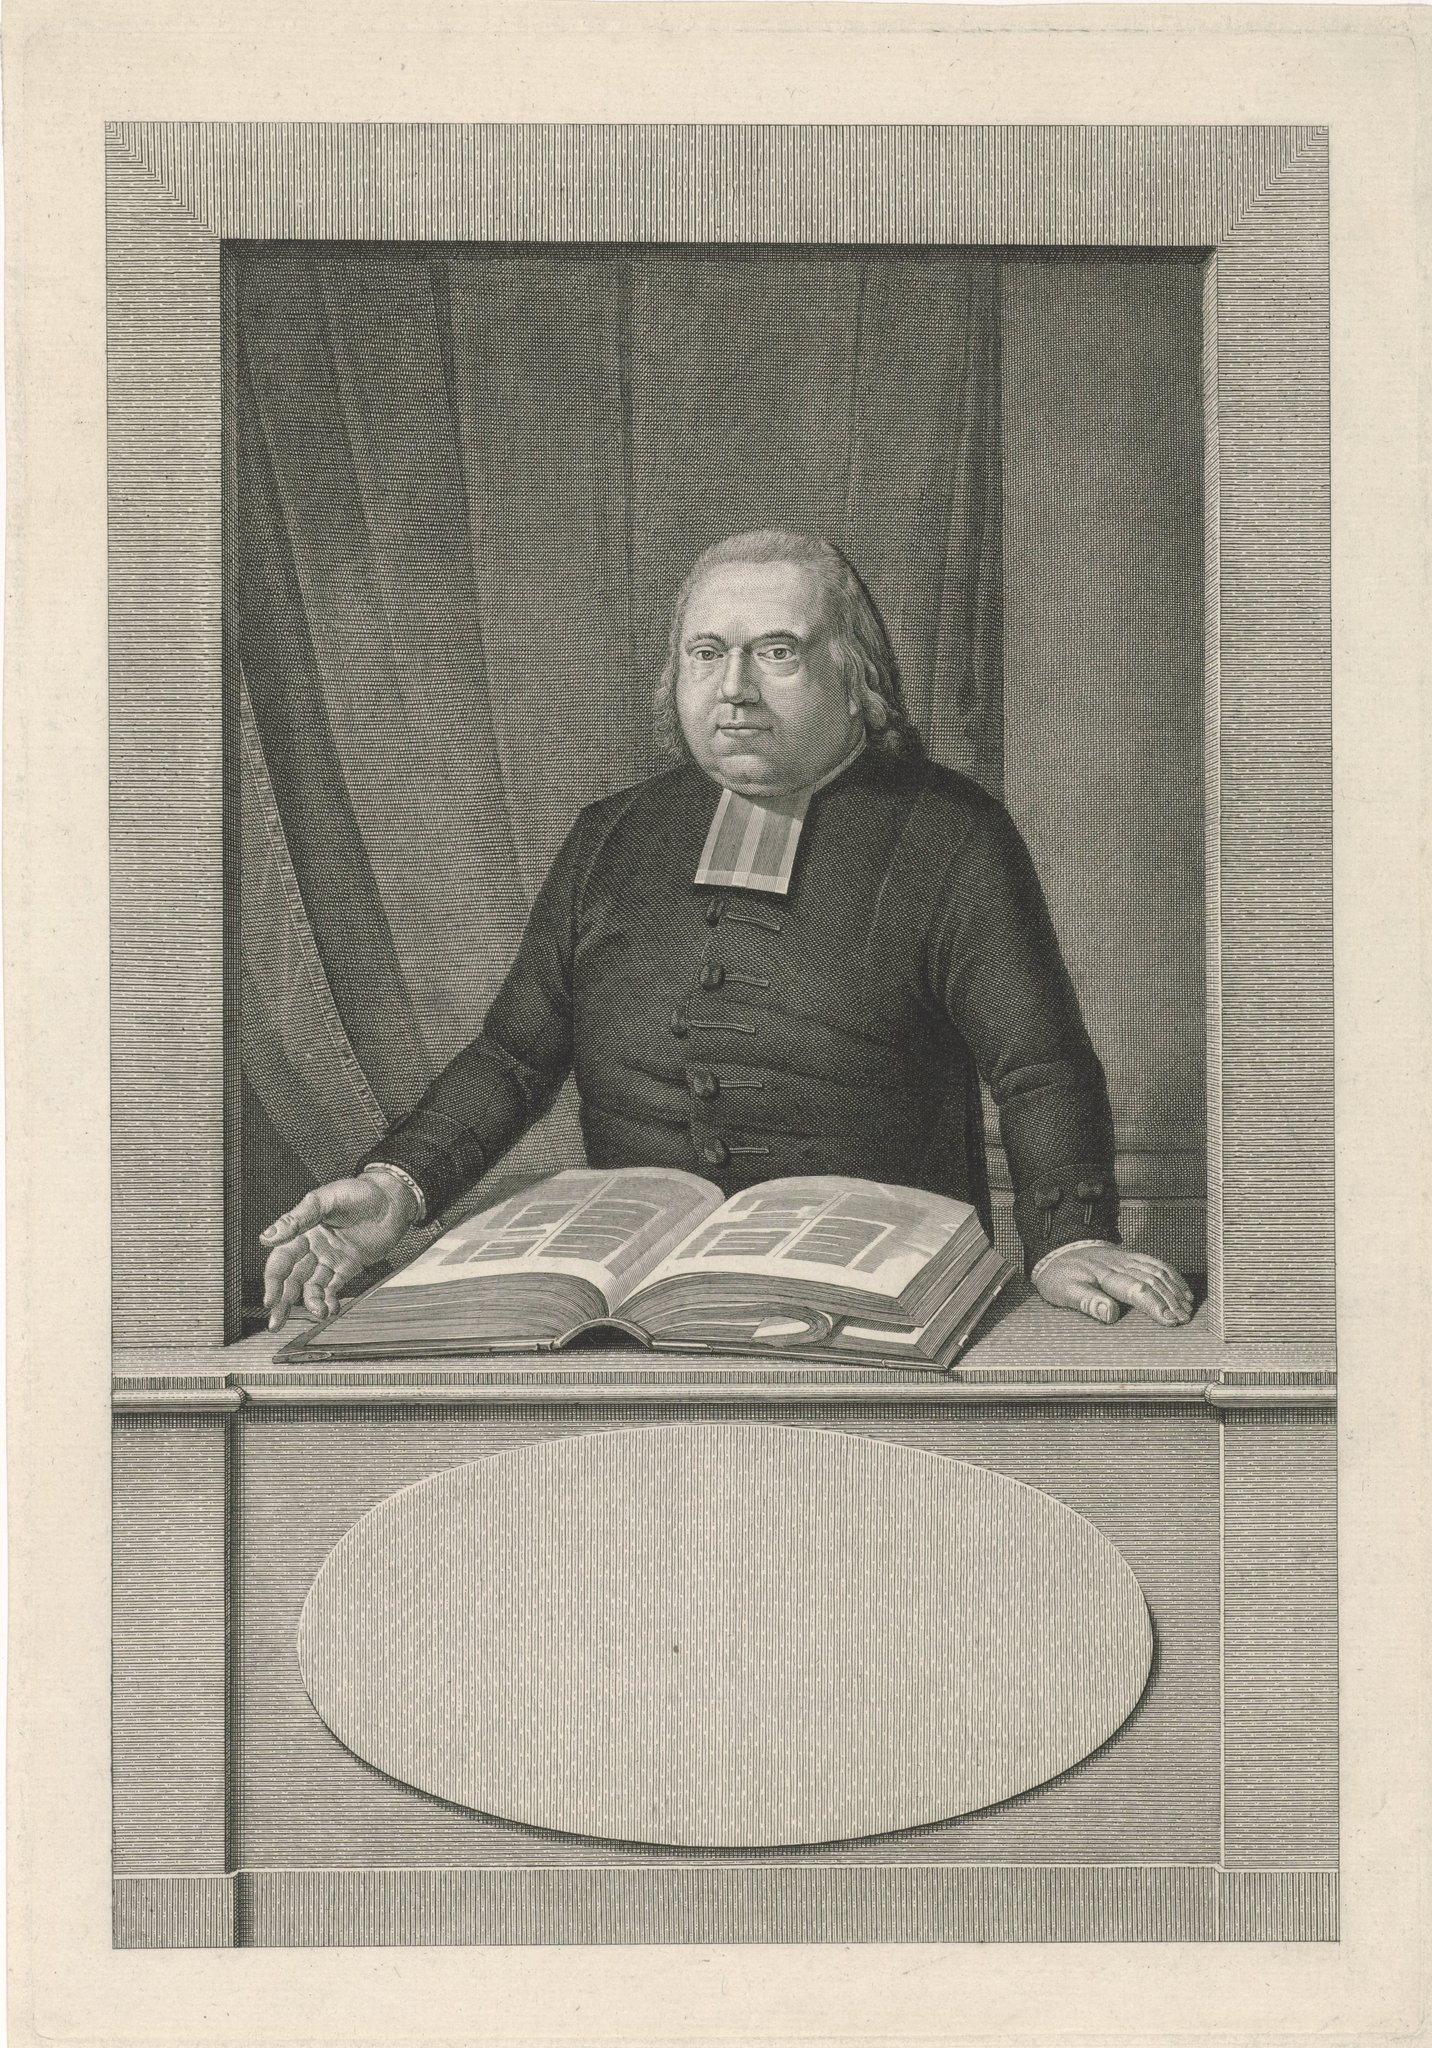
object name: print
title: Portret van Theodorus Isaäcus Gerhardus van Essen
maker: noach van der meer (ii)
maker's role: draughtsman, print maker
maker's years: 1741-1822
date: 1792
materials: paper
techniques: engraving, etching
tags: the bible as a book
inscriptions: collector's mark: Lugt 2228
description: Portret van Theodorus Isaäcus Gerhardus van Essen, predikant te Amsterdam, staande bij een opengeslagen Bijbel.